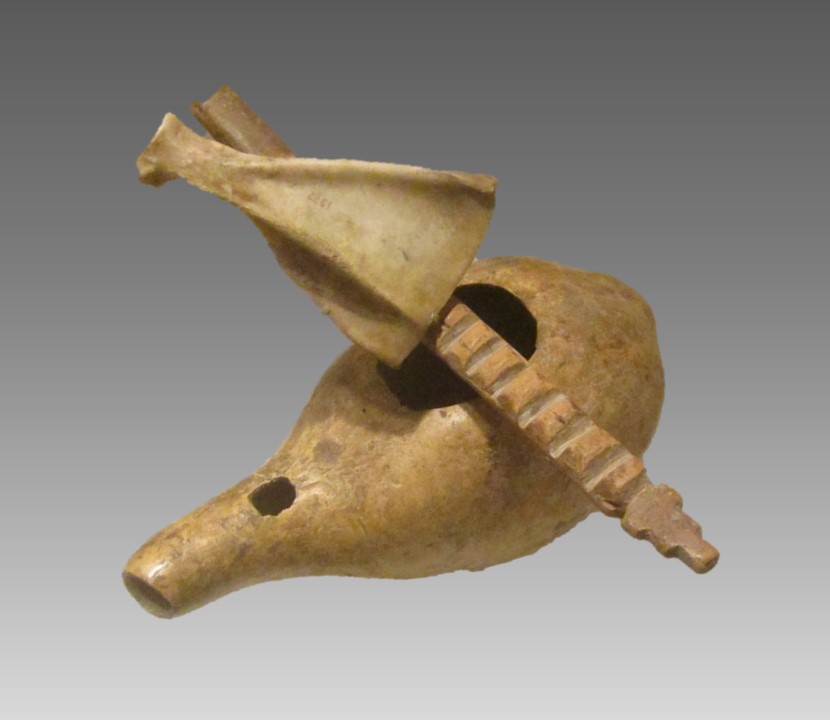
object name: truh kun pi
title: Truh-kun-pi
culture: native american, hopi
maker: hopi indians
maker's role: maker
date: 1801-1900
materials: bone, wood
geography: united states